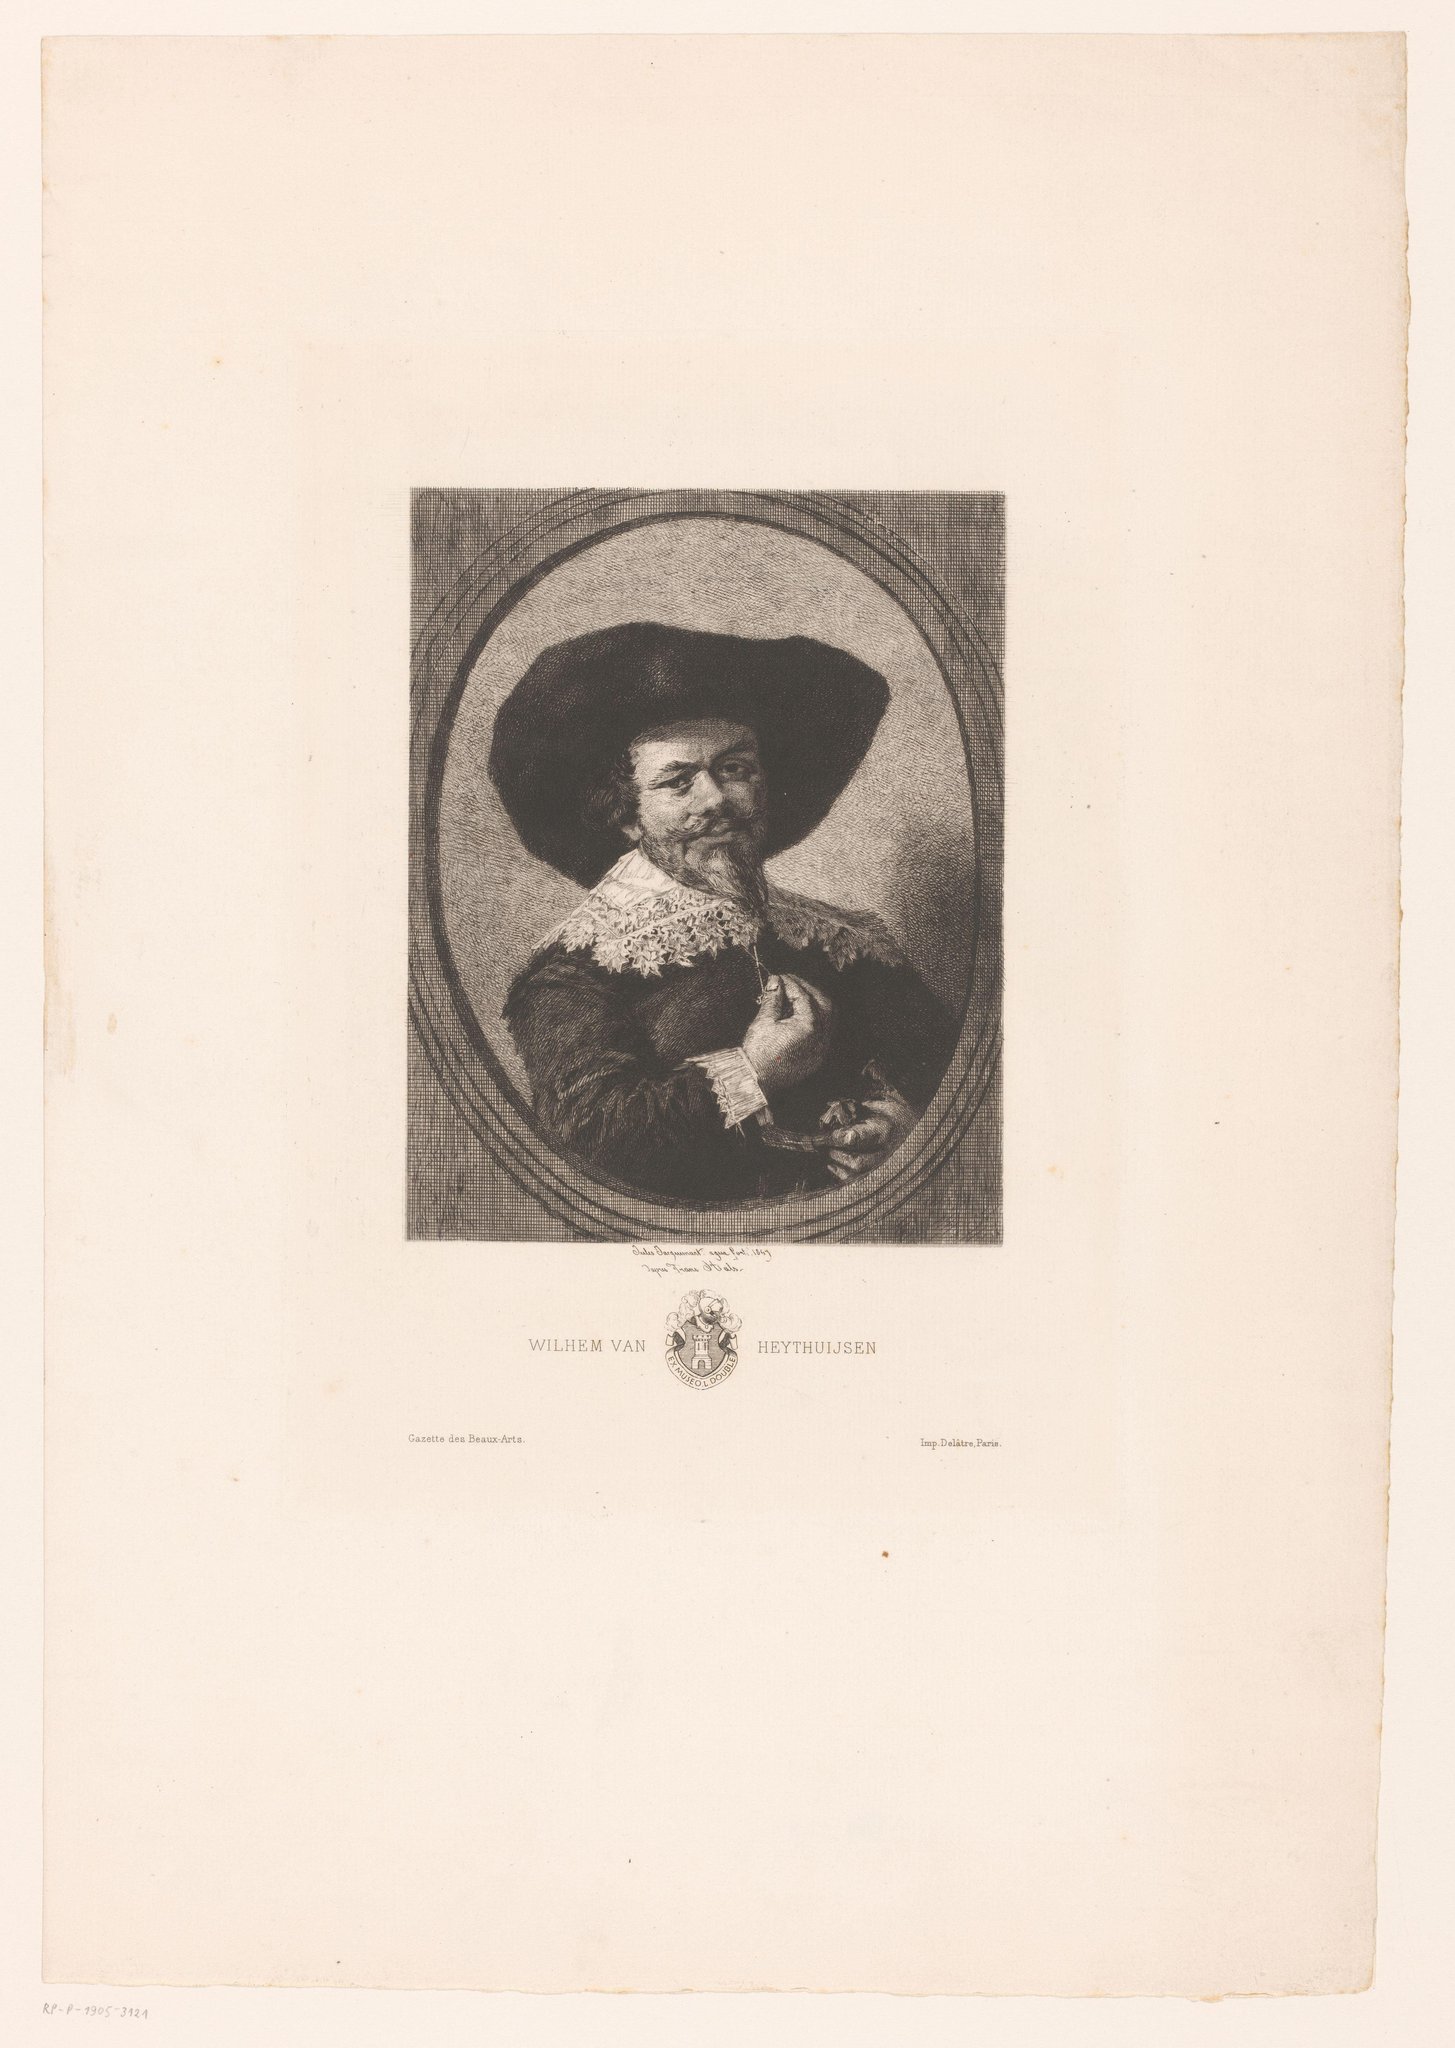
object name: print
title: Wilhelm van Heythuijsen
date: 1869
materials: paper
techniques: drypoint, etching, intaglio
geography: france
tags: haarlem, ornament ~ medallion, historical persons, merchant, salesman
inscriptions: collector's mark: Lugt 2228